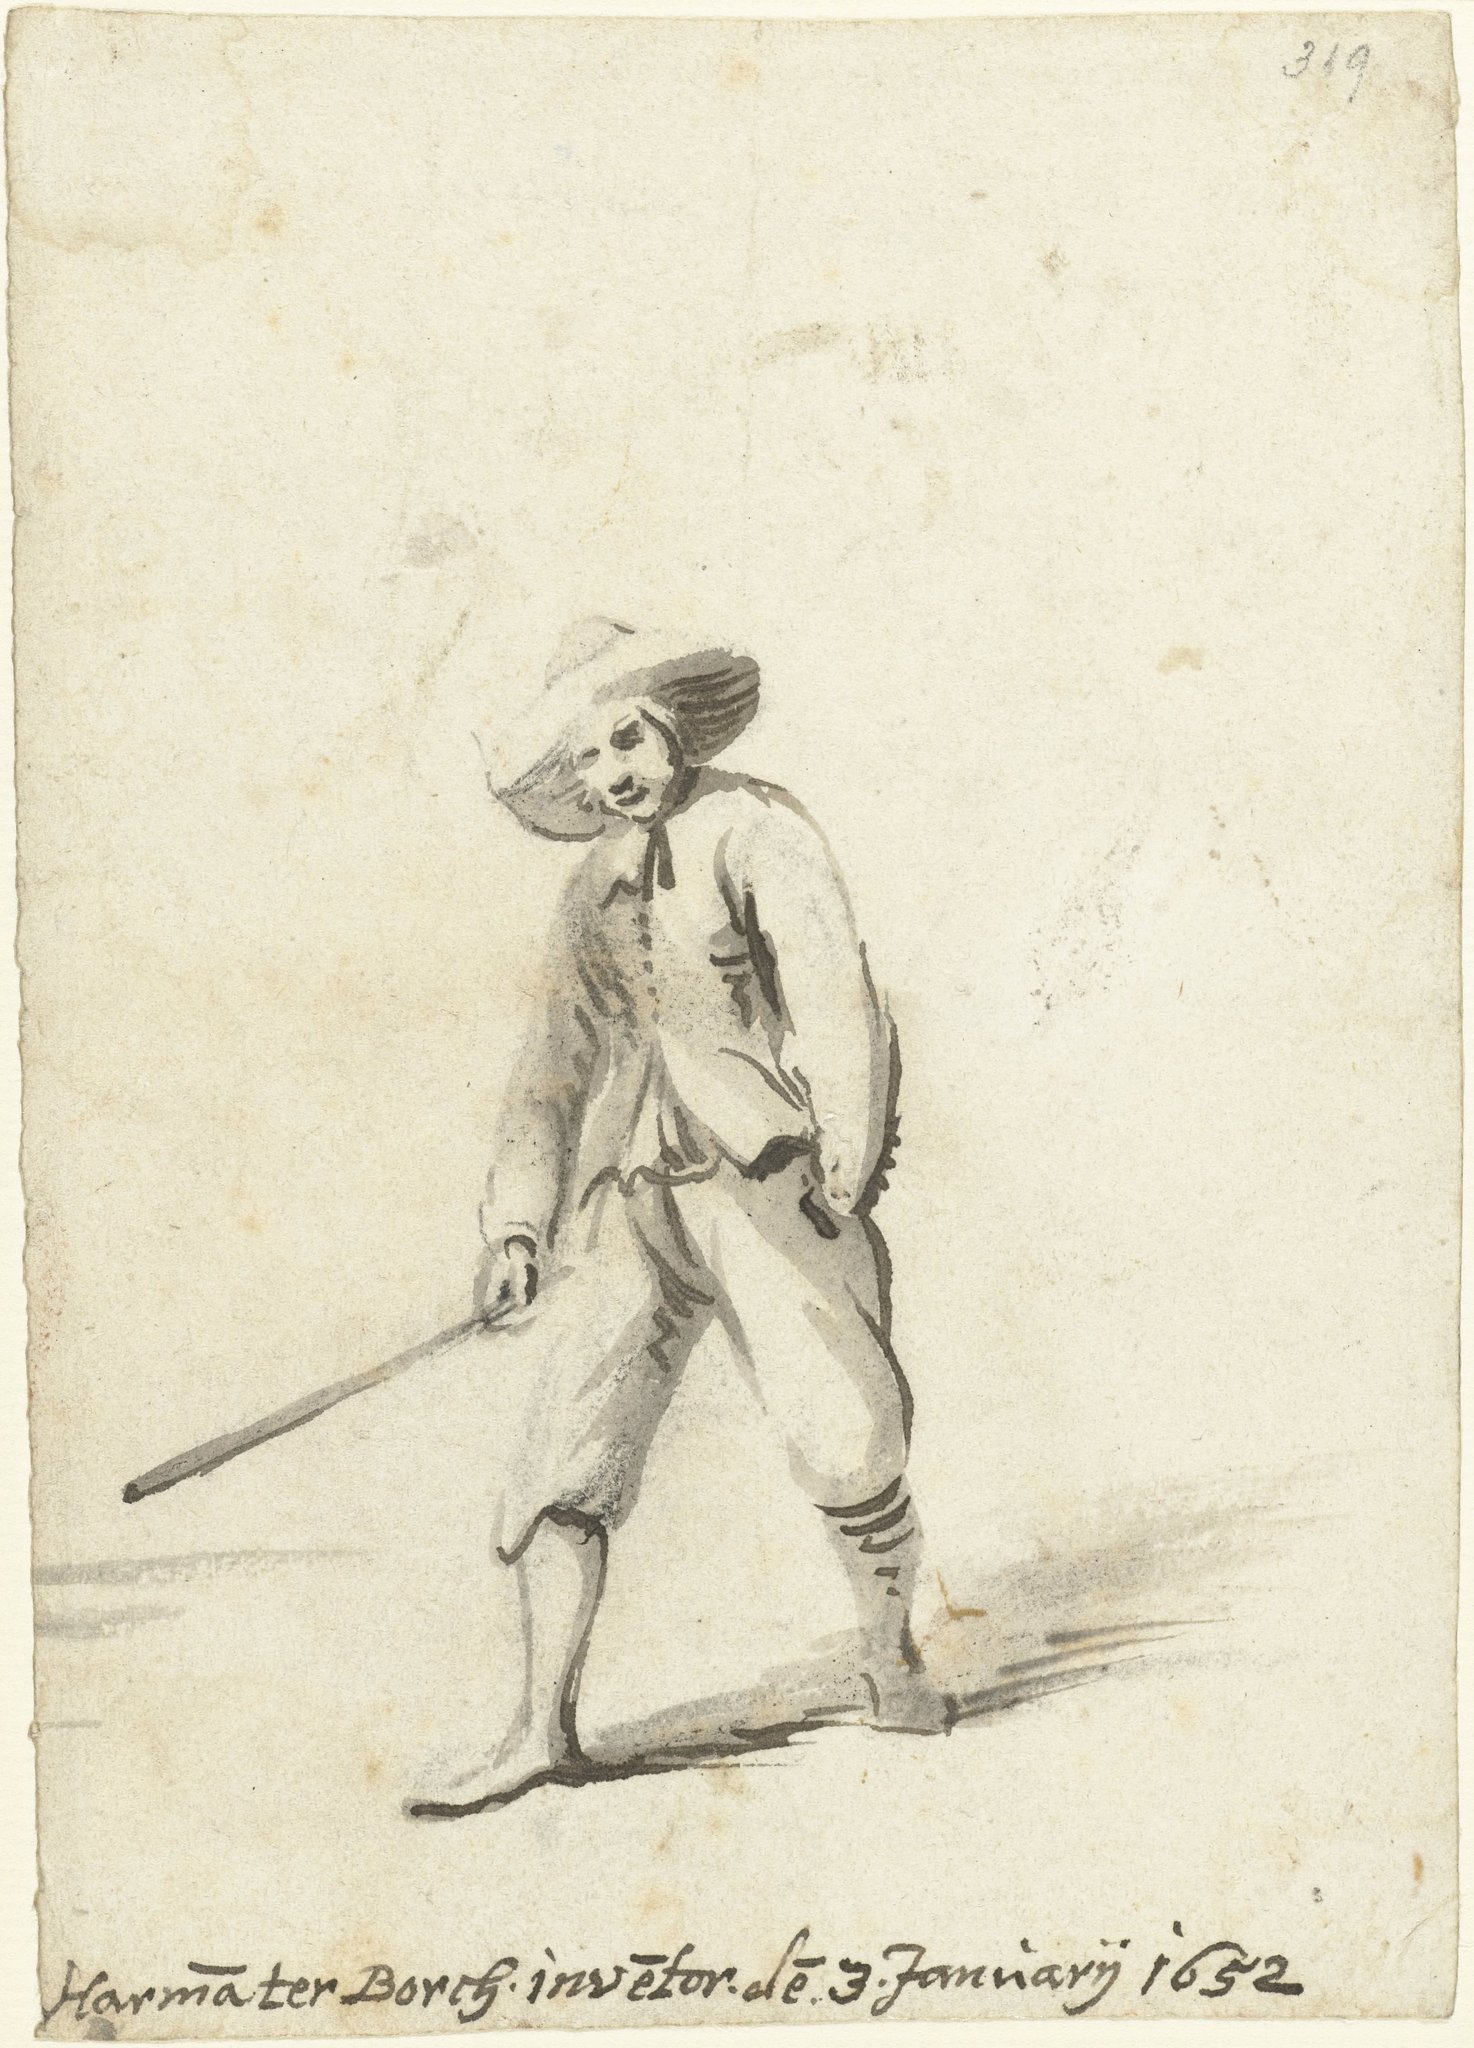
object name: drawing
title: Man met stok, naar links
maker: harmen ter borch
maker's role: draughtsman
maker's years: 1638-1677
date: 1652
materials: chalk, ink, paper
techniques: brush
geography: zwolle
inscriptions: annotation: ‘Harma[n] ter Borch. inve[n]tor.de[n].3.January 1652’